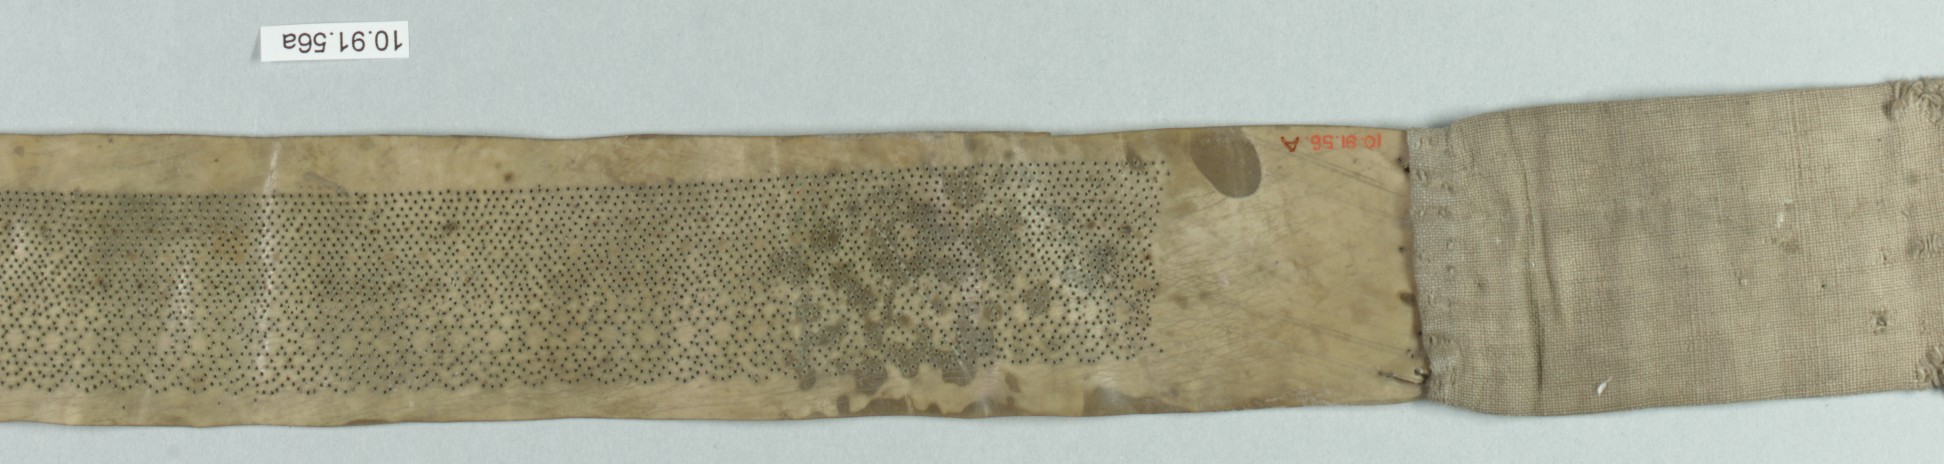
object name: pricking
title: Prickings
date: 1701-1900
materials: parchment